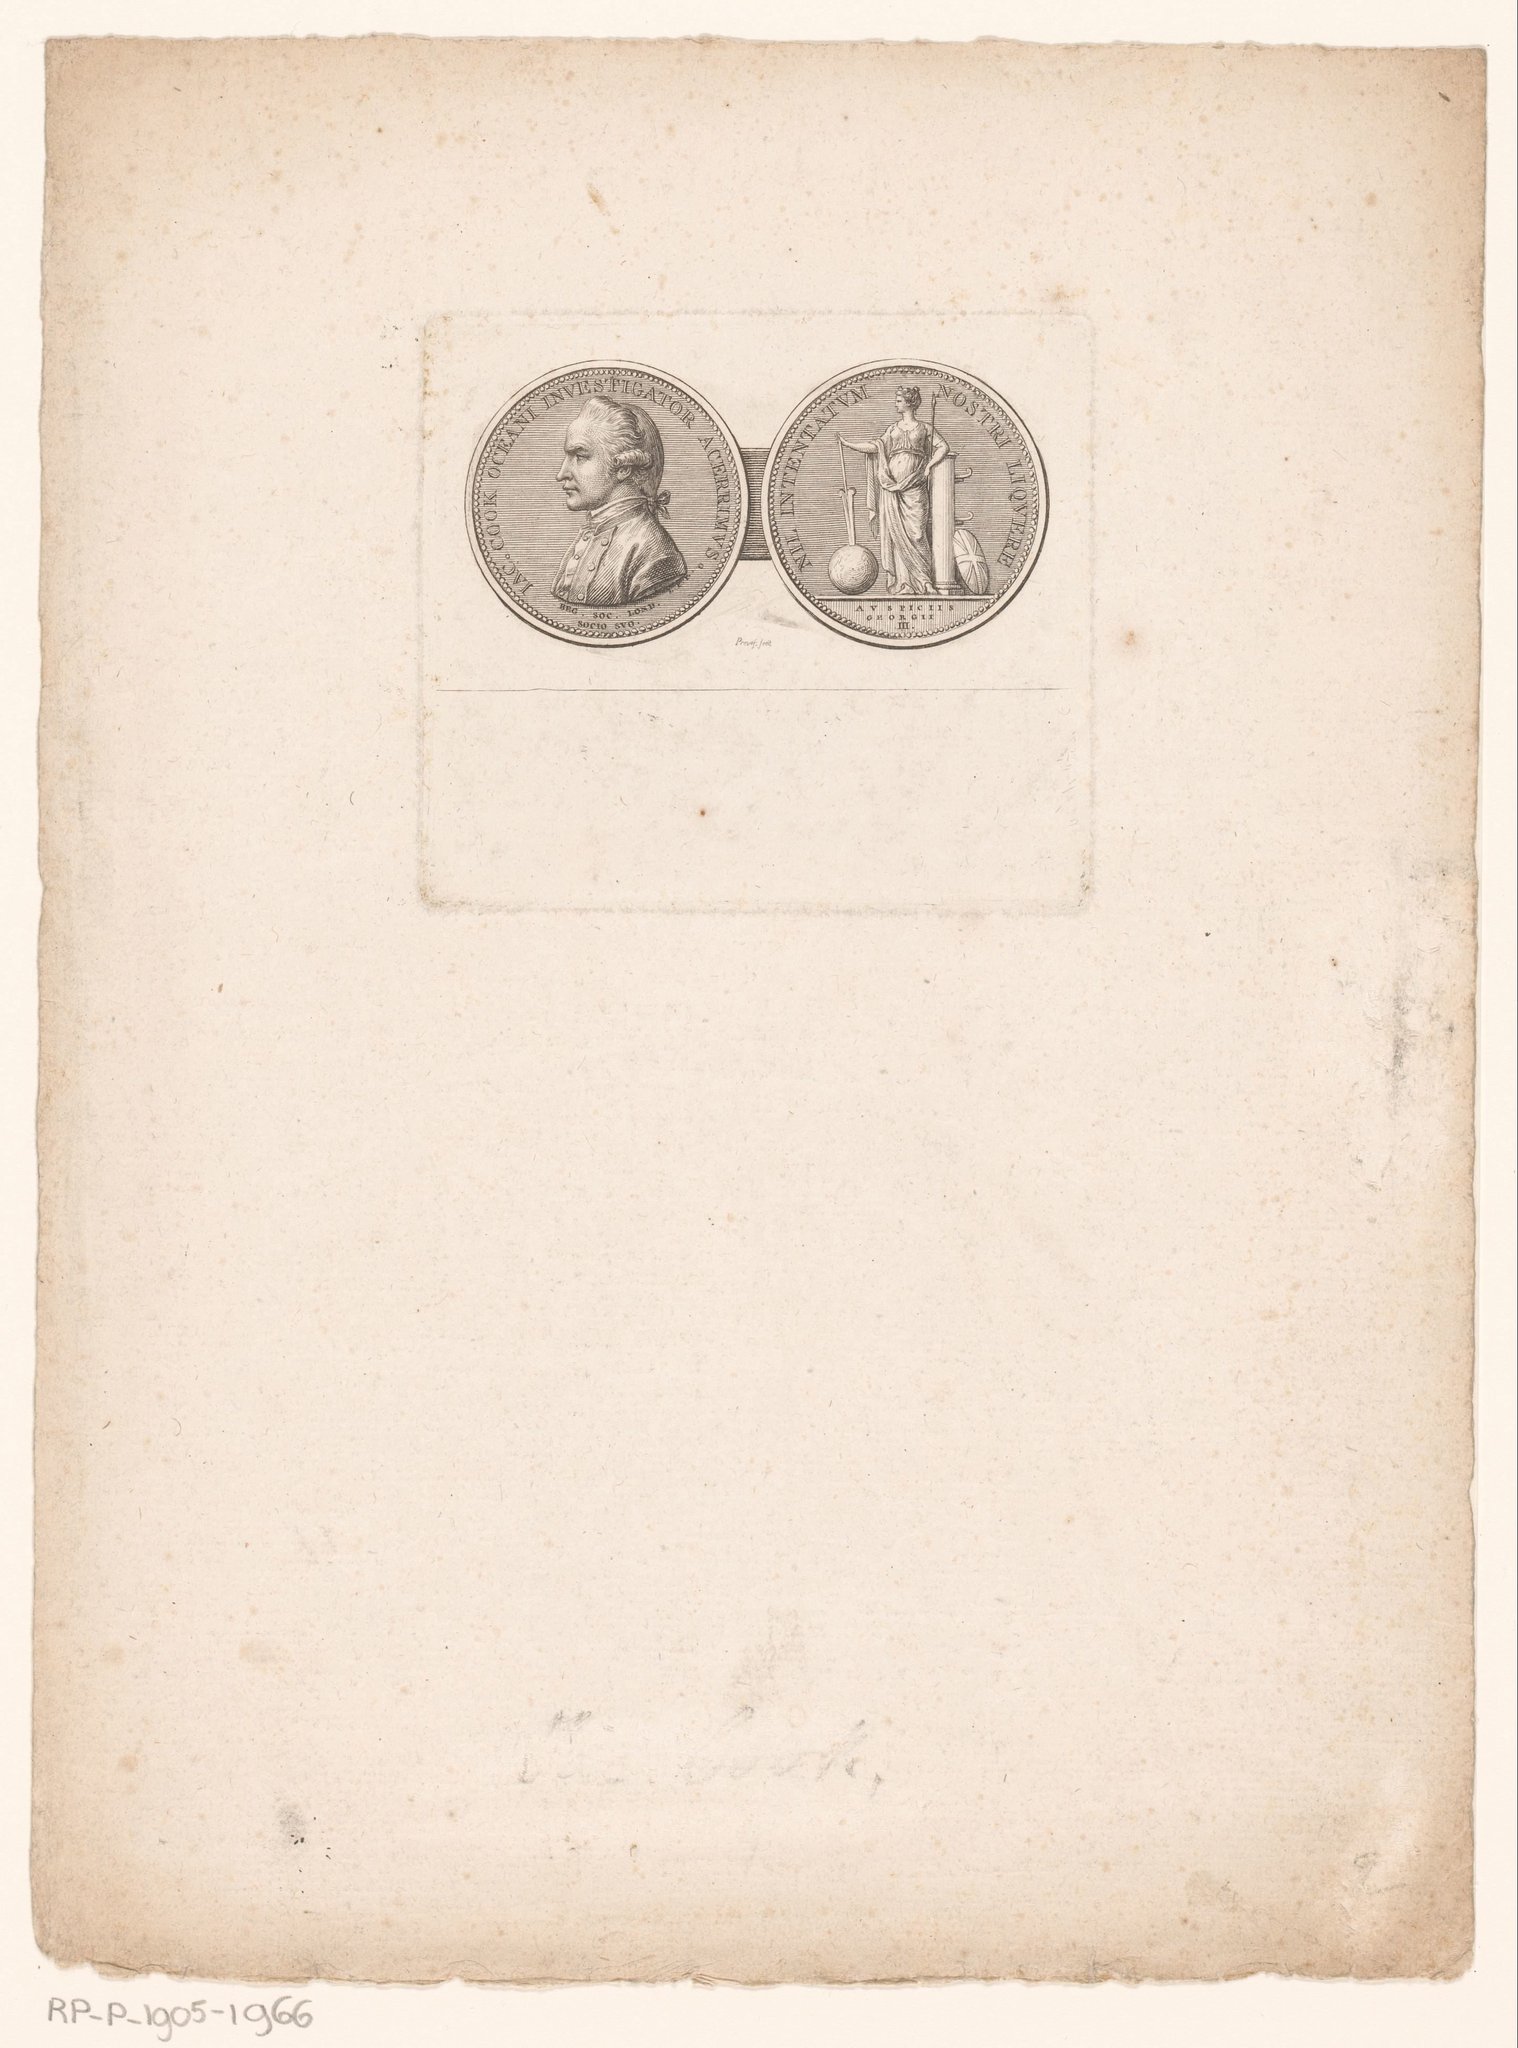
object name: print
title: Twee zijdes van een medaille met het portret van James Cook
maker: benoit louis prevost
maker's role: print maker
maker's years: 1747-1809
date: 1757-1809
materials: paper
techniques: engraving, etching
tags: james cook, historical persons, memorial medal, explorer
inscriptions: collector's mark: Lugt 2228